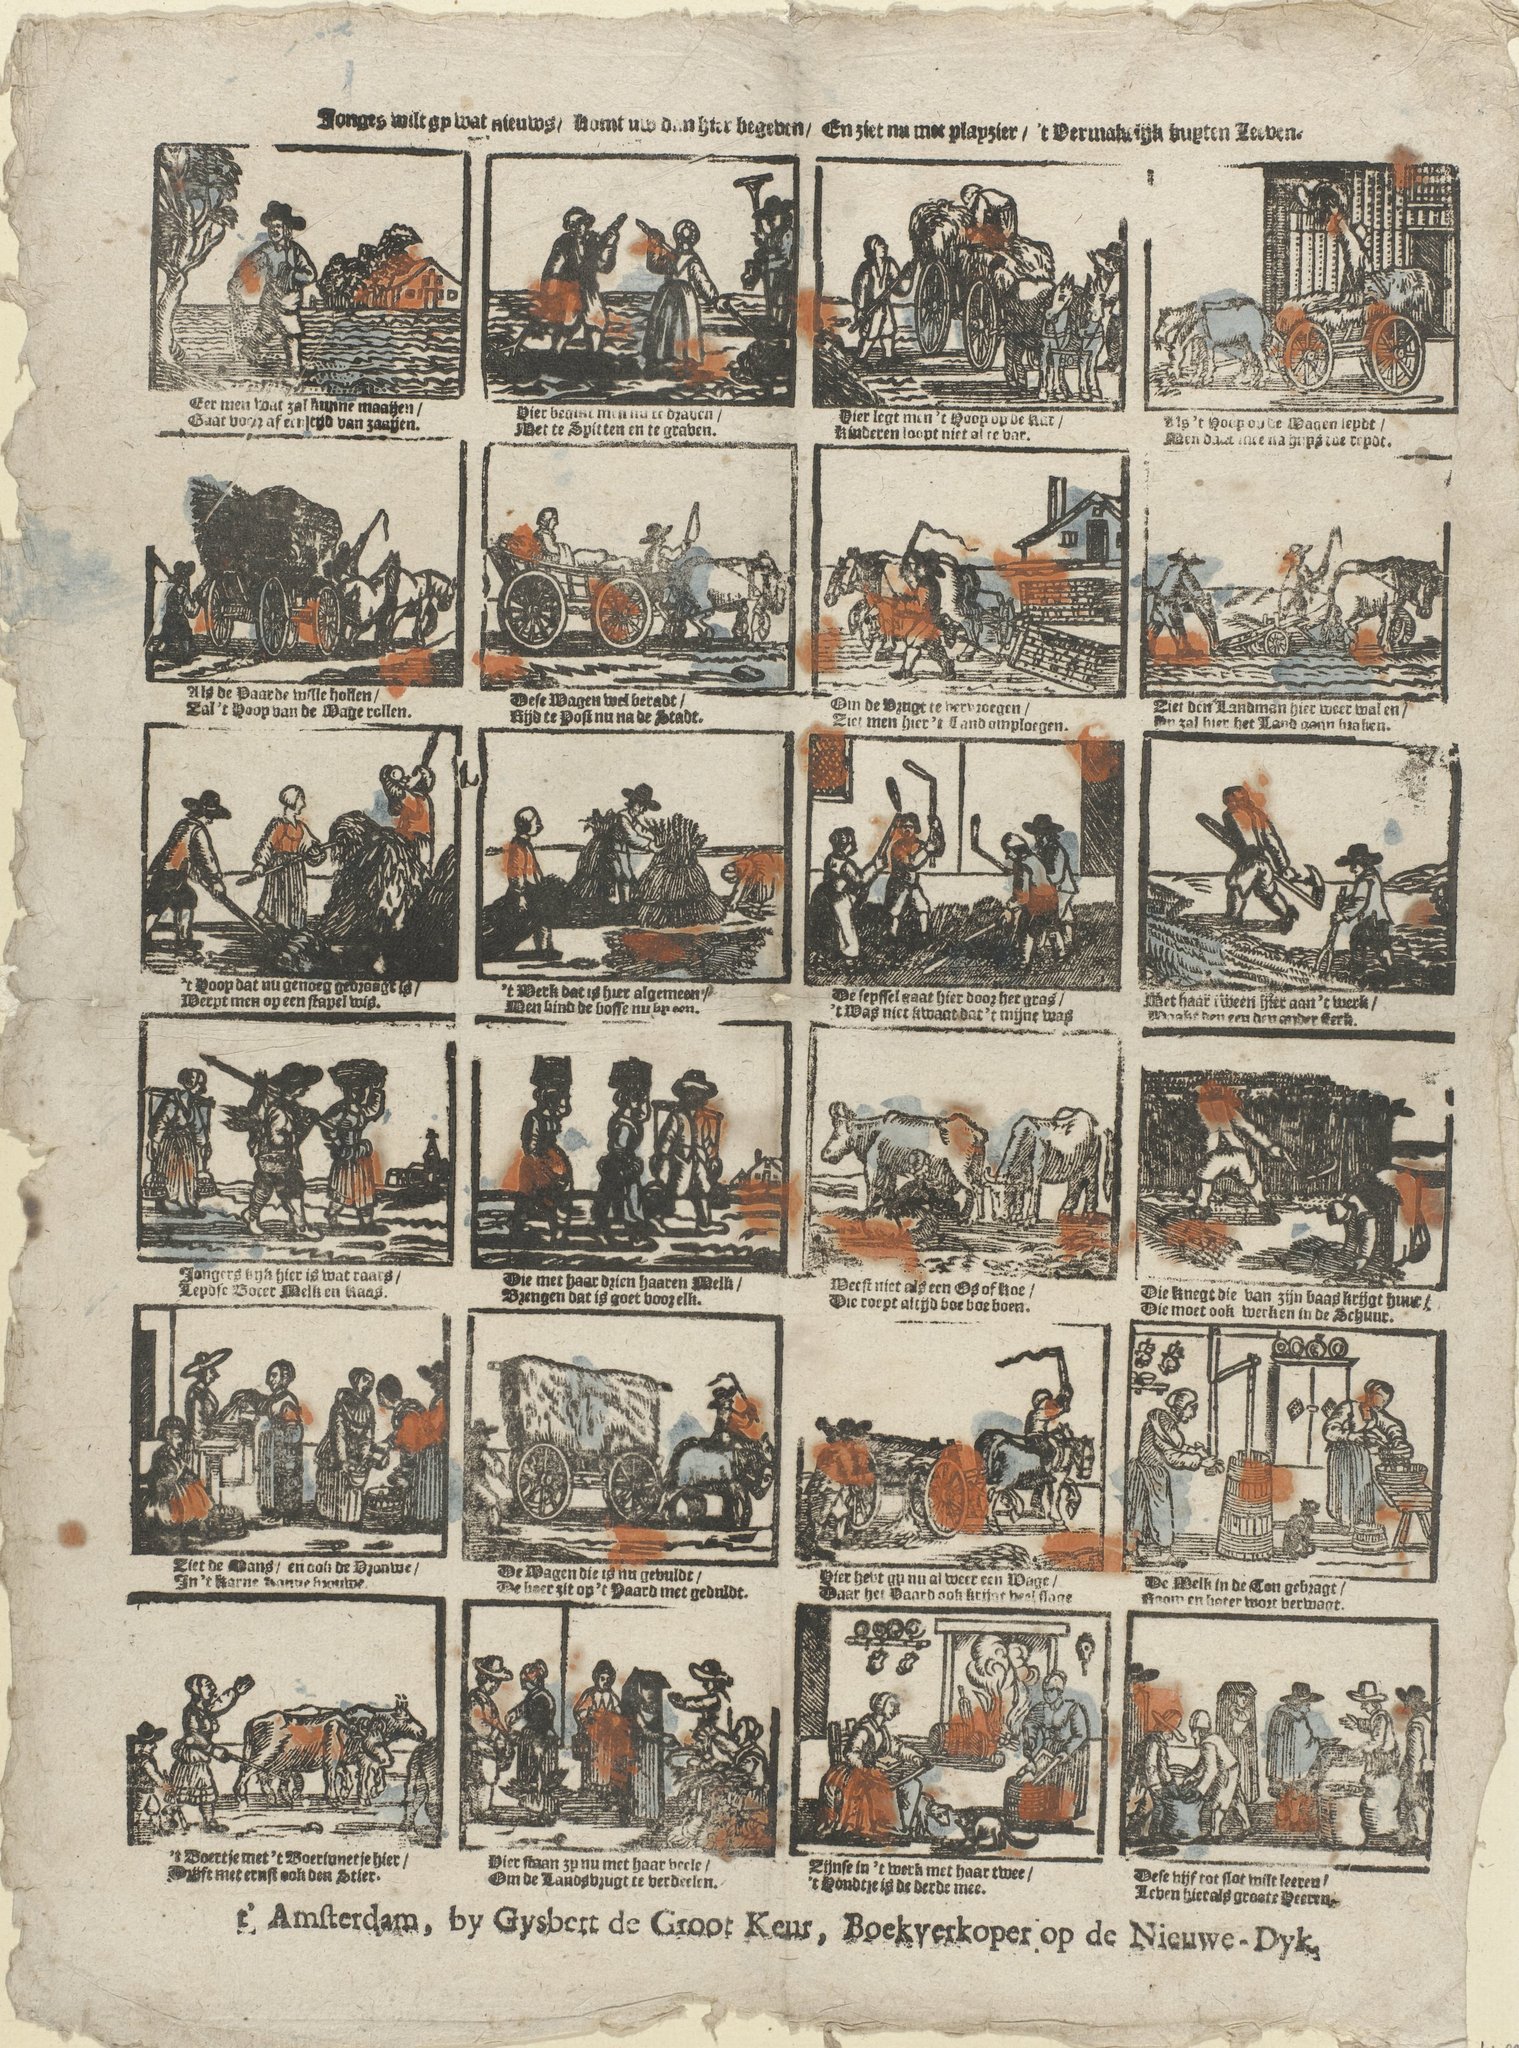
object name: print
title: Jongens wilt gy wat nieuws (...)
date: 1738-1767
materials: paper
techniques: colour, letterpress printing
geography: amsterdam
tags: agricultural implements, cereal, grain, corn (grass with grains, grown for food, e.g.: wheat, rice, rye, oats, maize, buckwheat, millet), agriculture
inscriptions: collector's mark: Lugt 2228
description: Blad met 24 voorstellingen van werkende boeren en boerinnen. Onder elke afbeelding een tweeregelig vers.